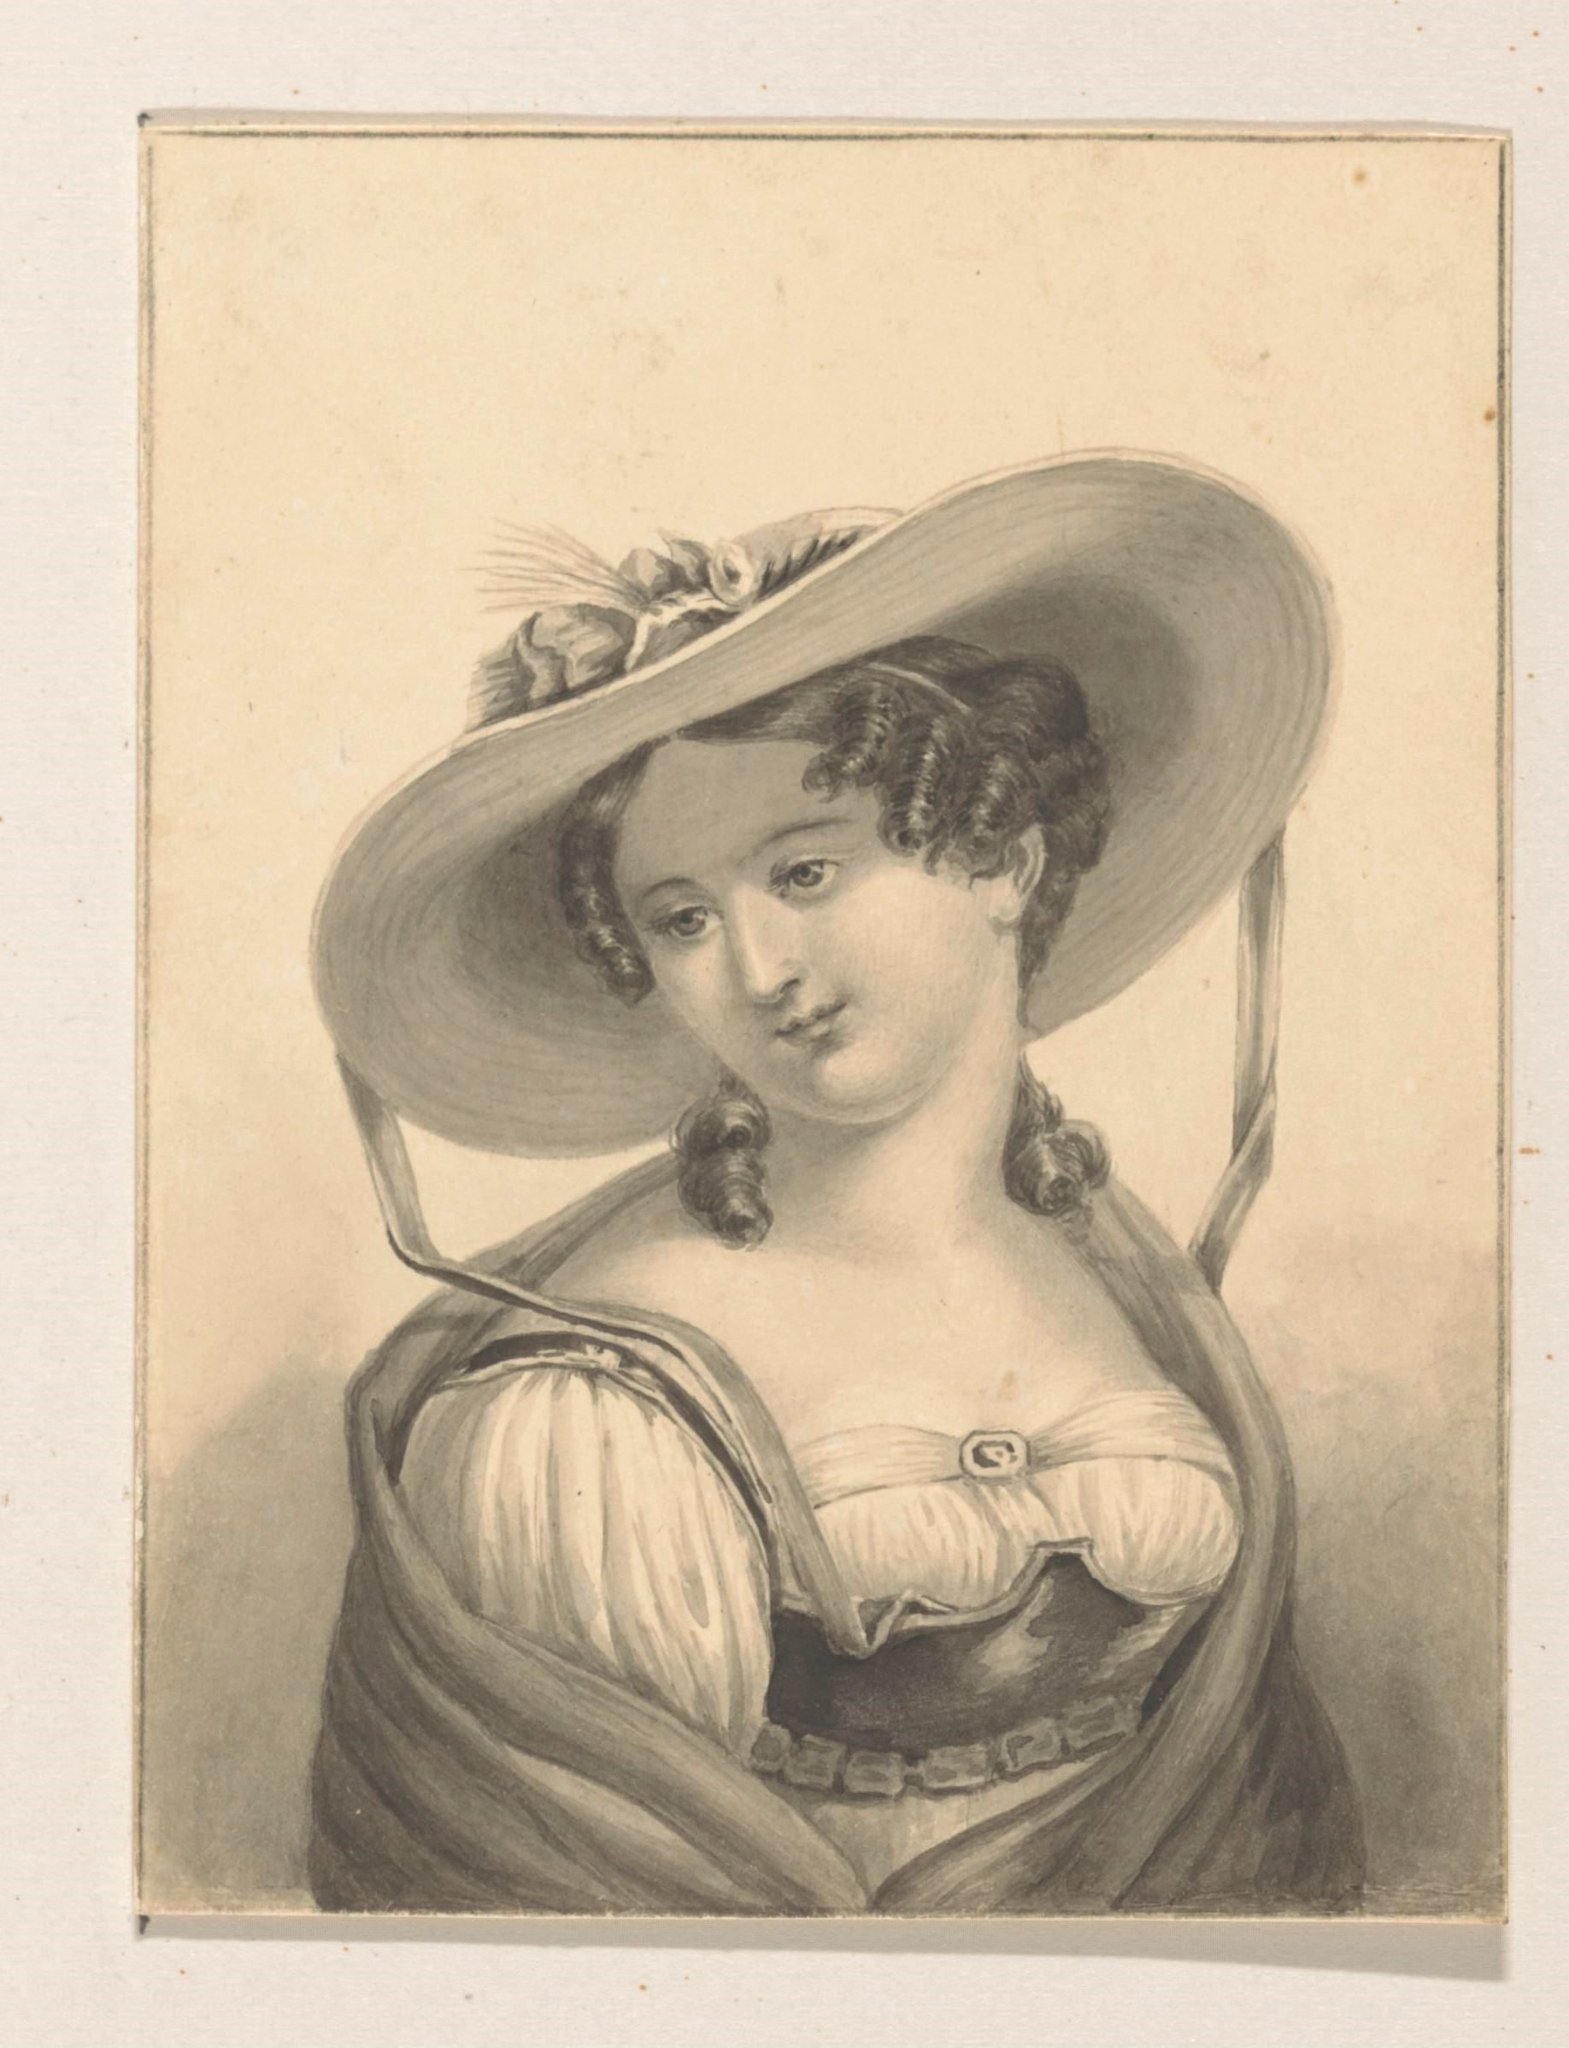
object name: drawing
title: Meisje met hoed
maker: pieter cornelis van den velden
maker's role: draughtsman, print maker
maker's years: 1806-1828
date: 1827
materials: paper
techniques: brush